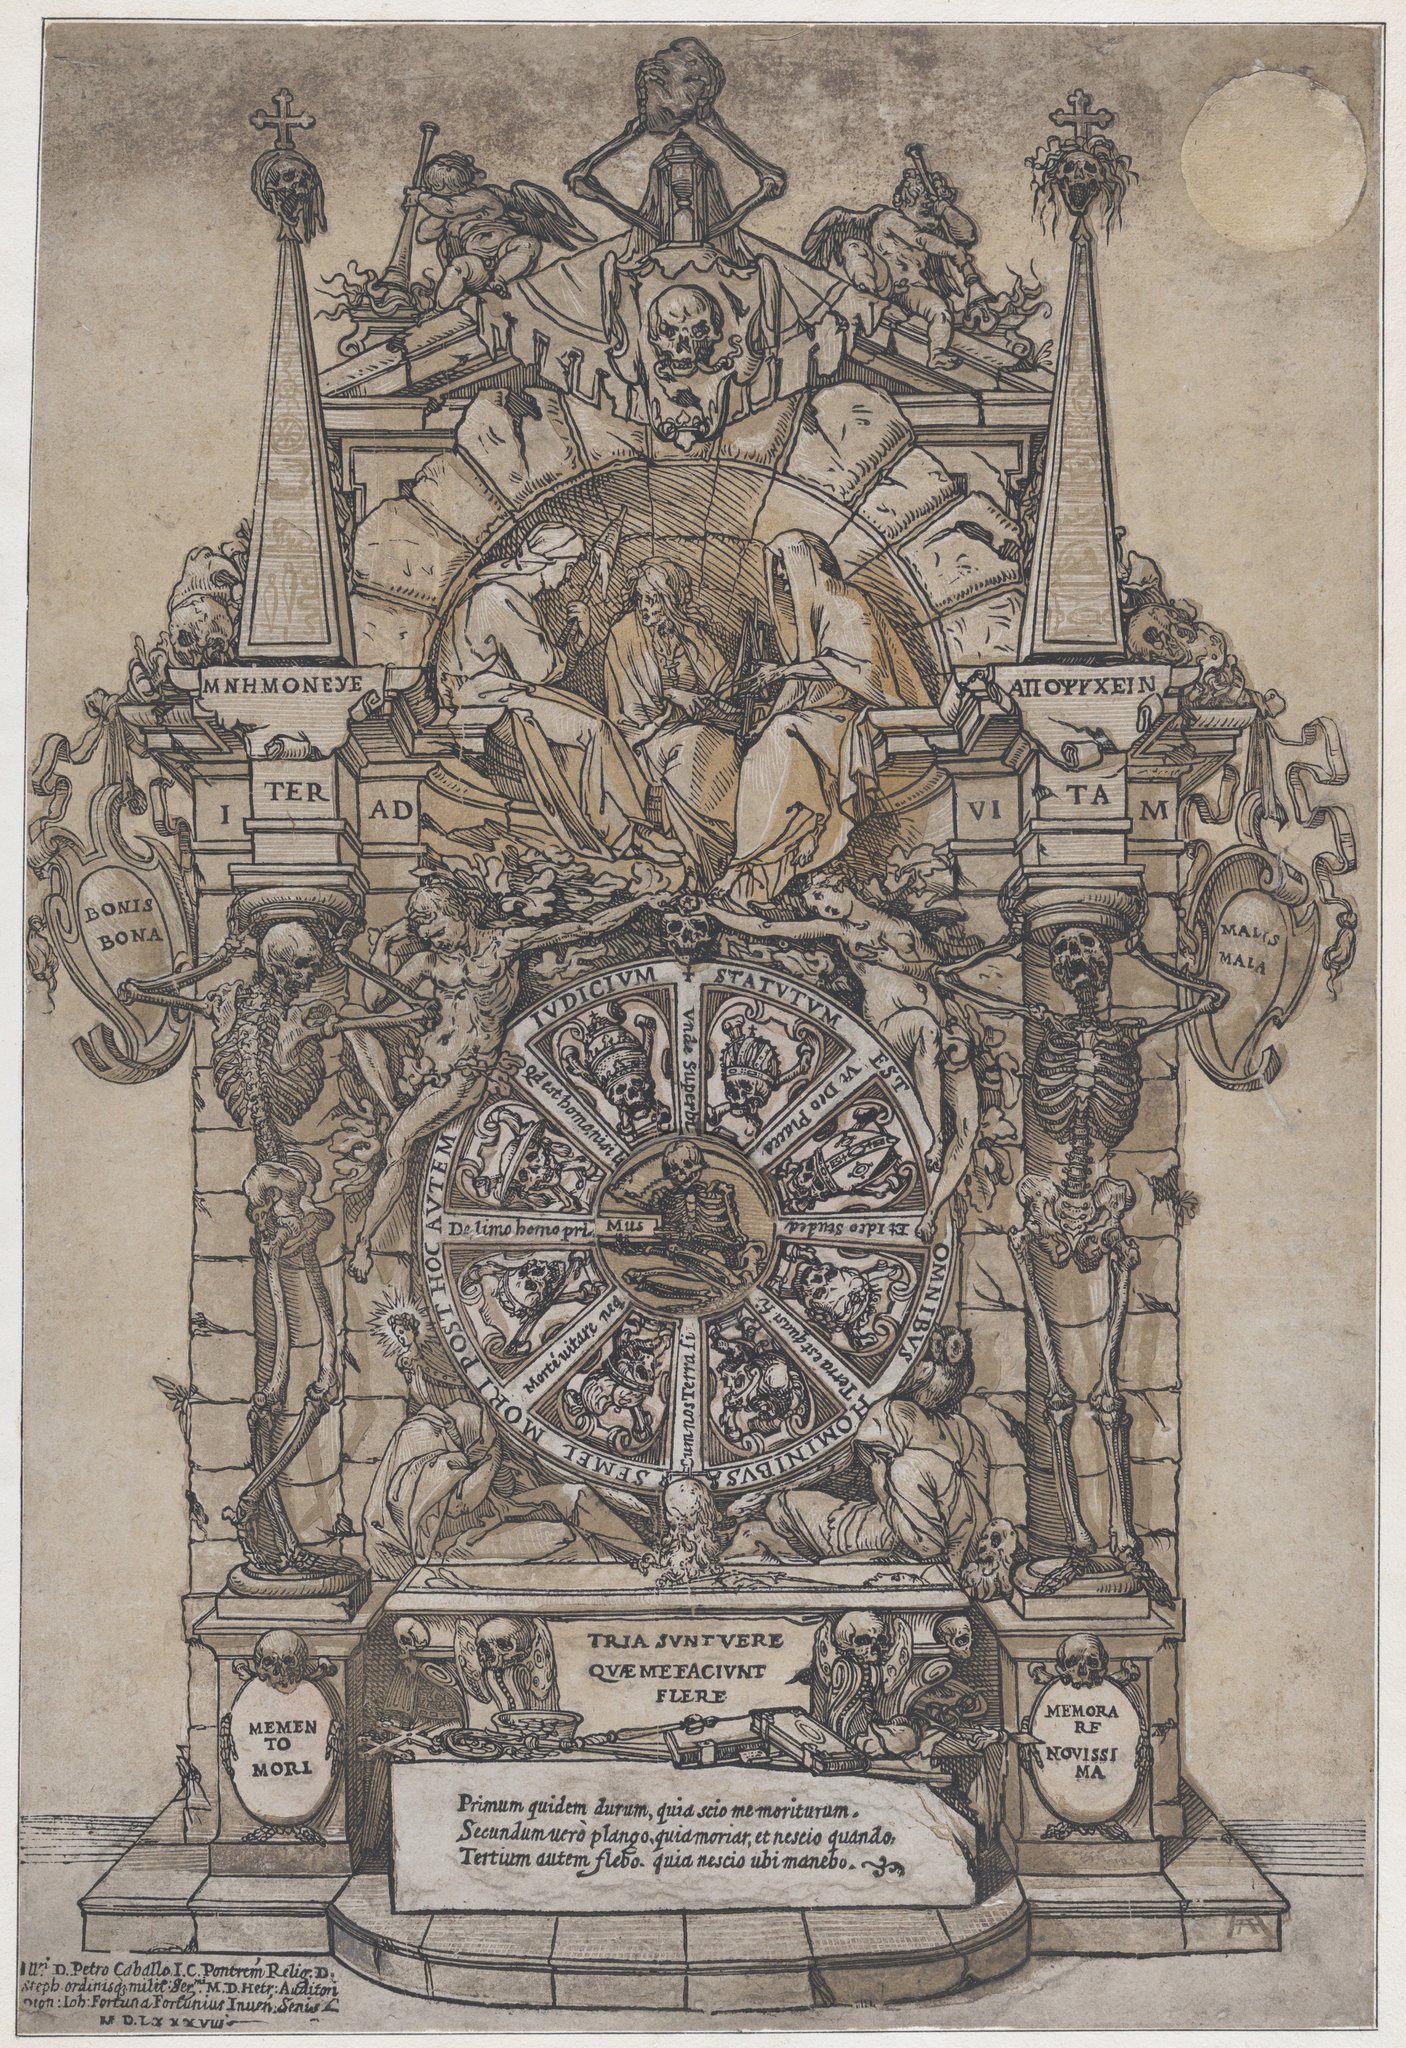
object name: print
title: Triumph of Death with three fates in an architectural frame above a wheel of fortune flanked by skeletons; a skull and an hour glass at top and with wheel intended to spin at center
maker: andrea andreani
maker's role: artist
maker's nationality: italian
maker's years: 1558-1629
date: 1588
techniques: woodcut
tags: skeletons,skulls,cross,death